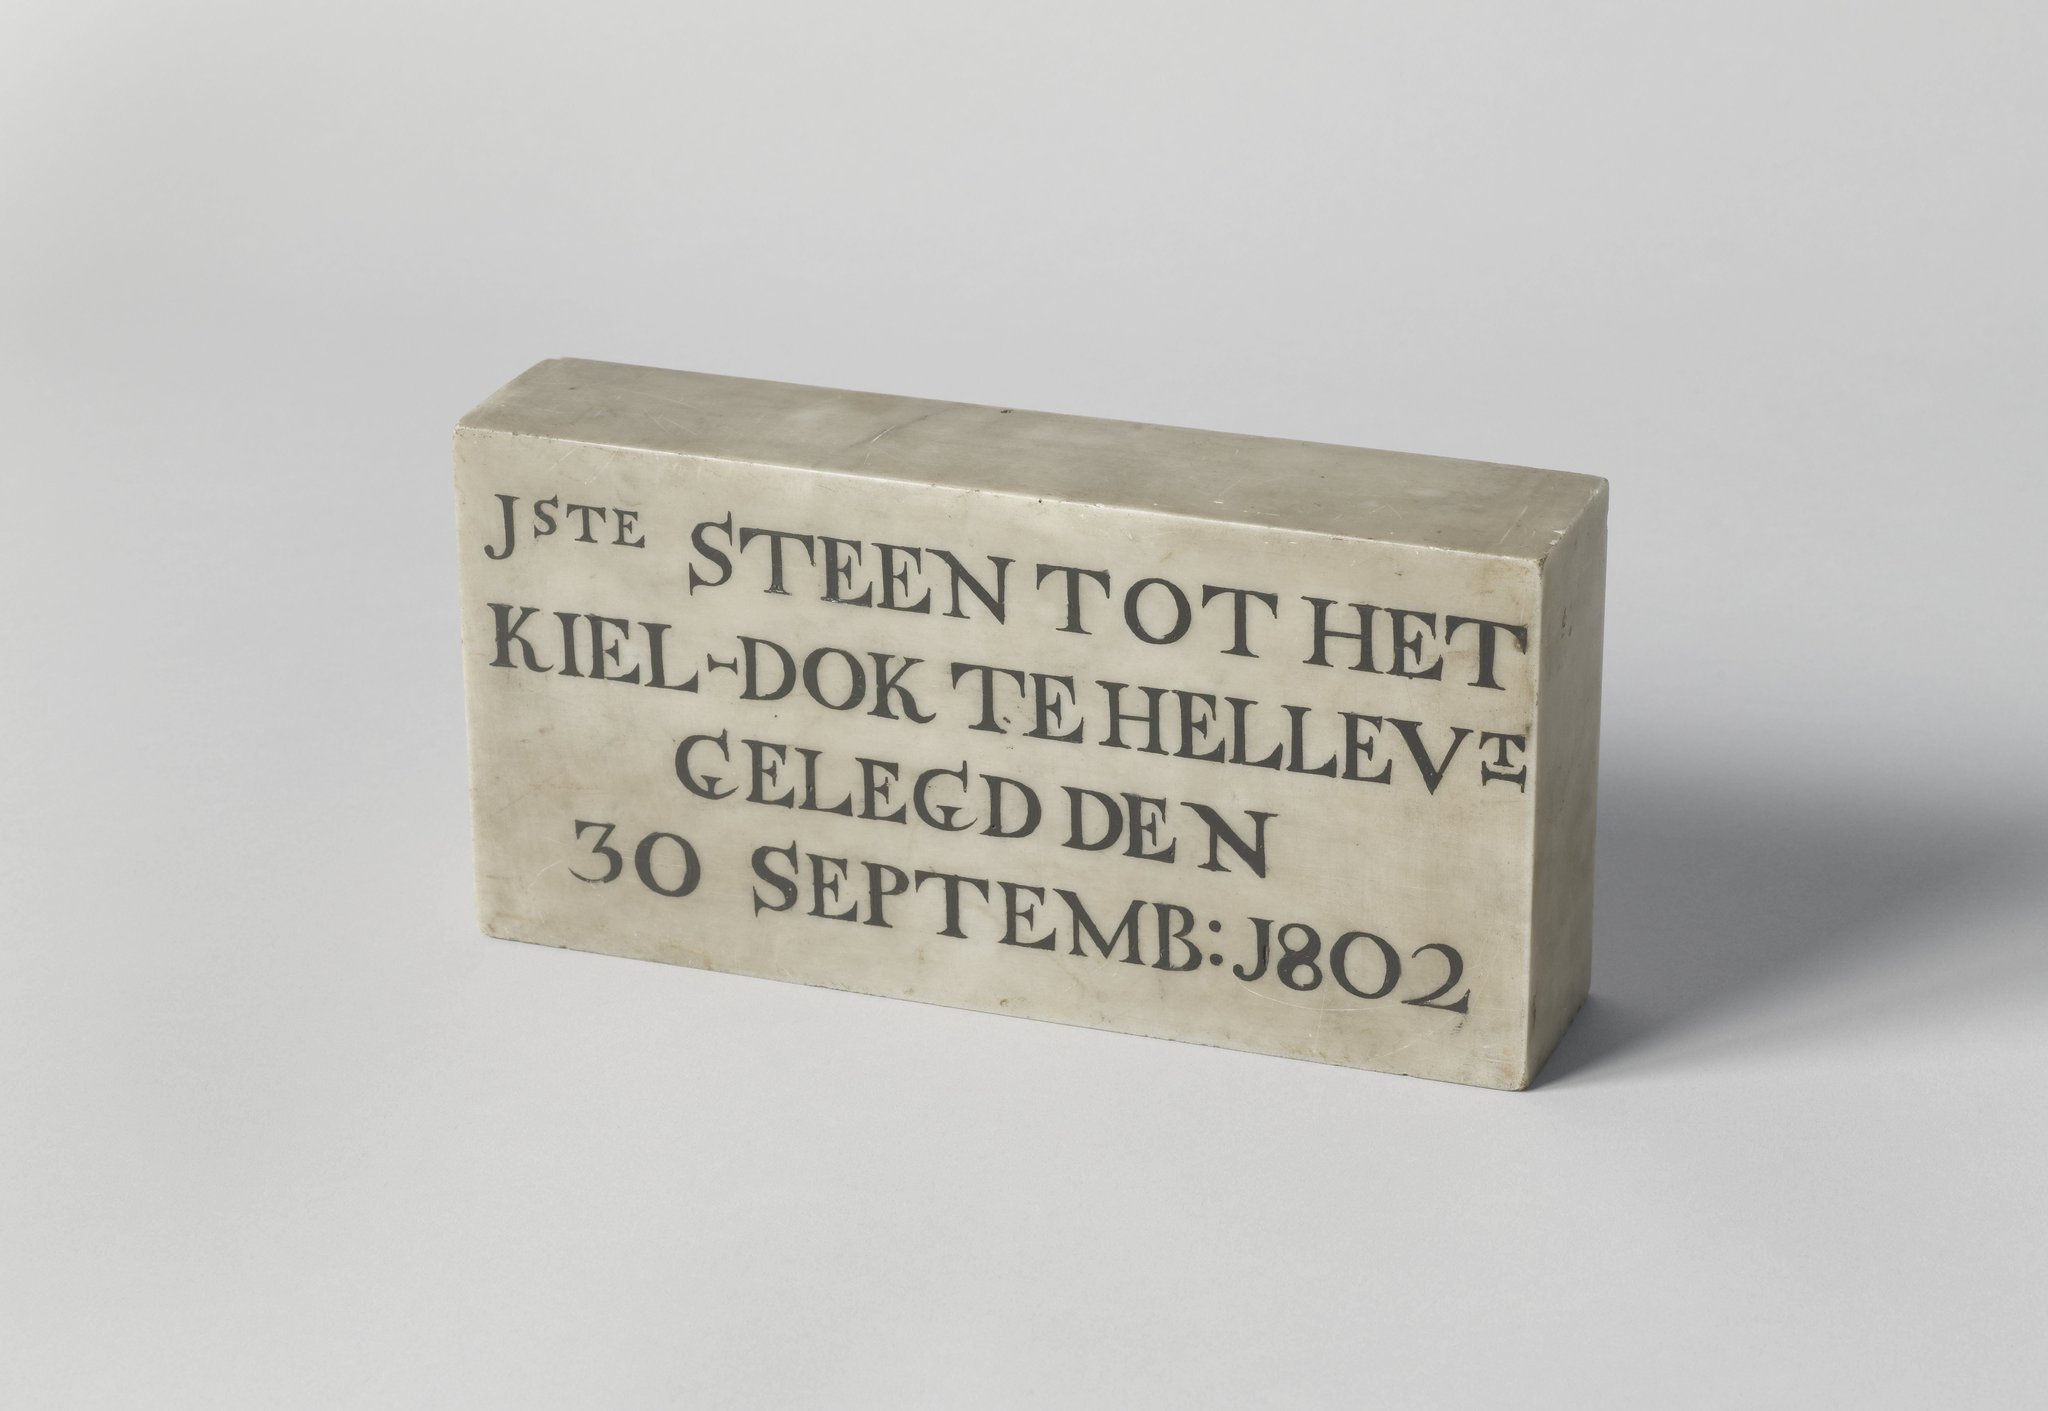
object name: steen objectnaam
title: Eerste steen van het kildok te Hellevoetsluis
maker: Anonymous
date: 1802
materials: marble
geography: netherlands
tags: hellevoetsluis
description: Kopie van eerste steen van marmer van het kildok te Hellevoetsluis, 30 september 1802.